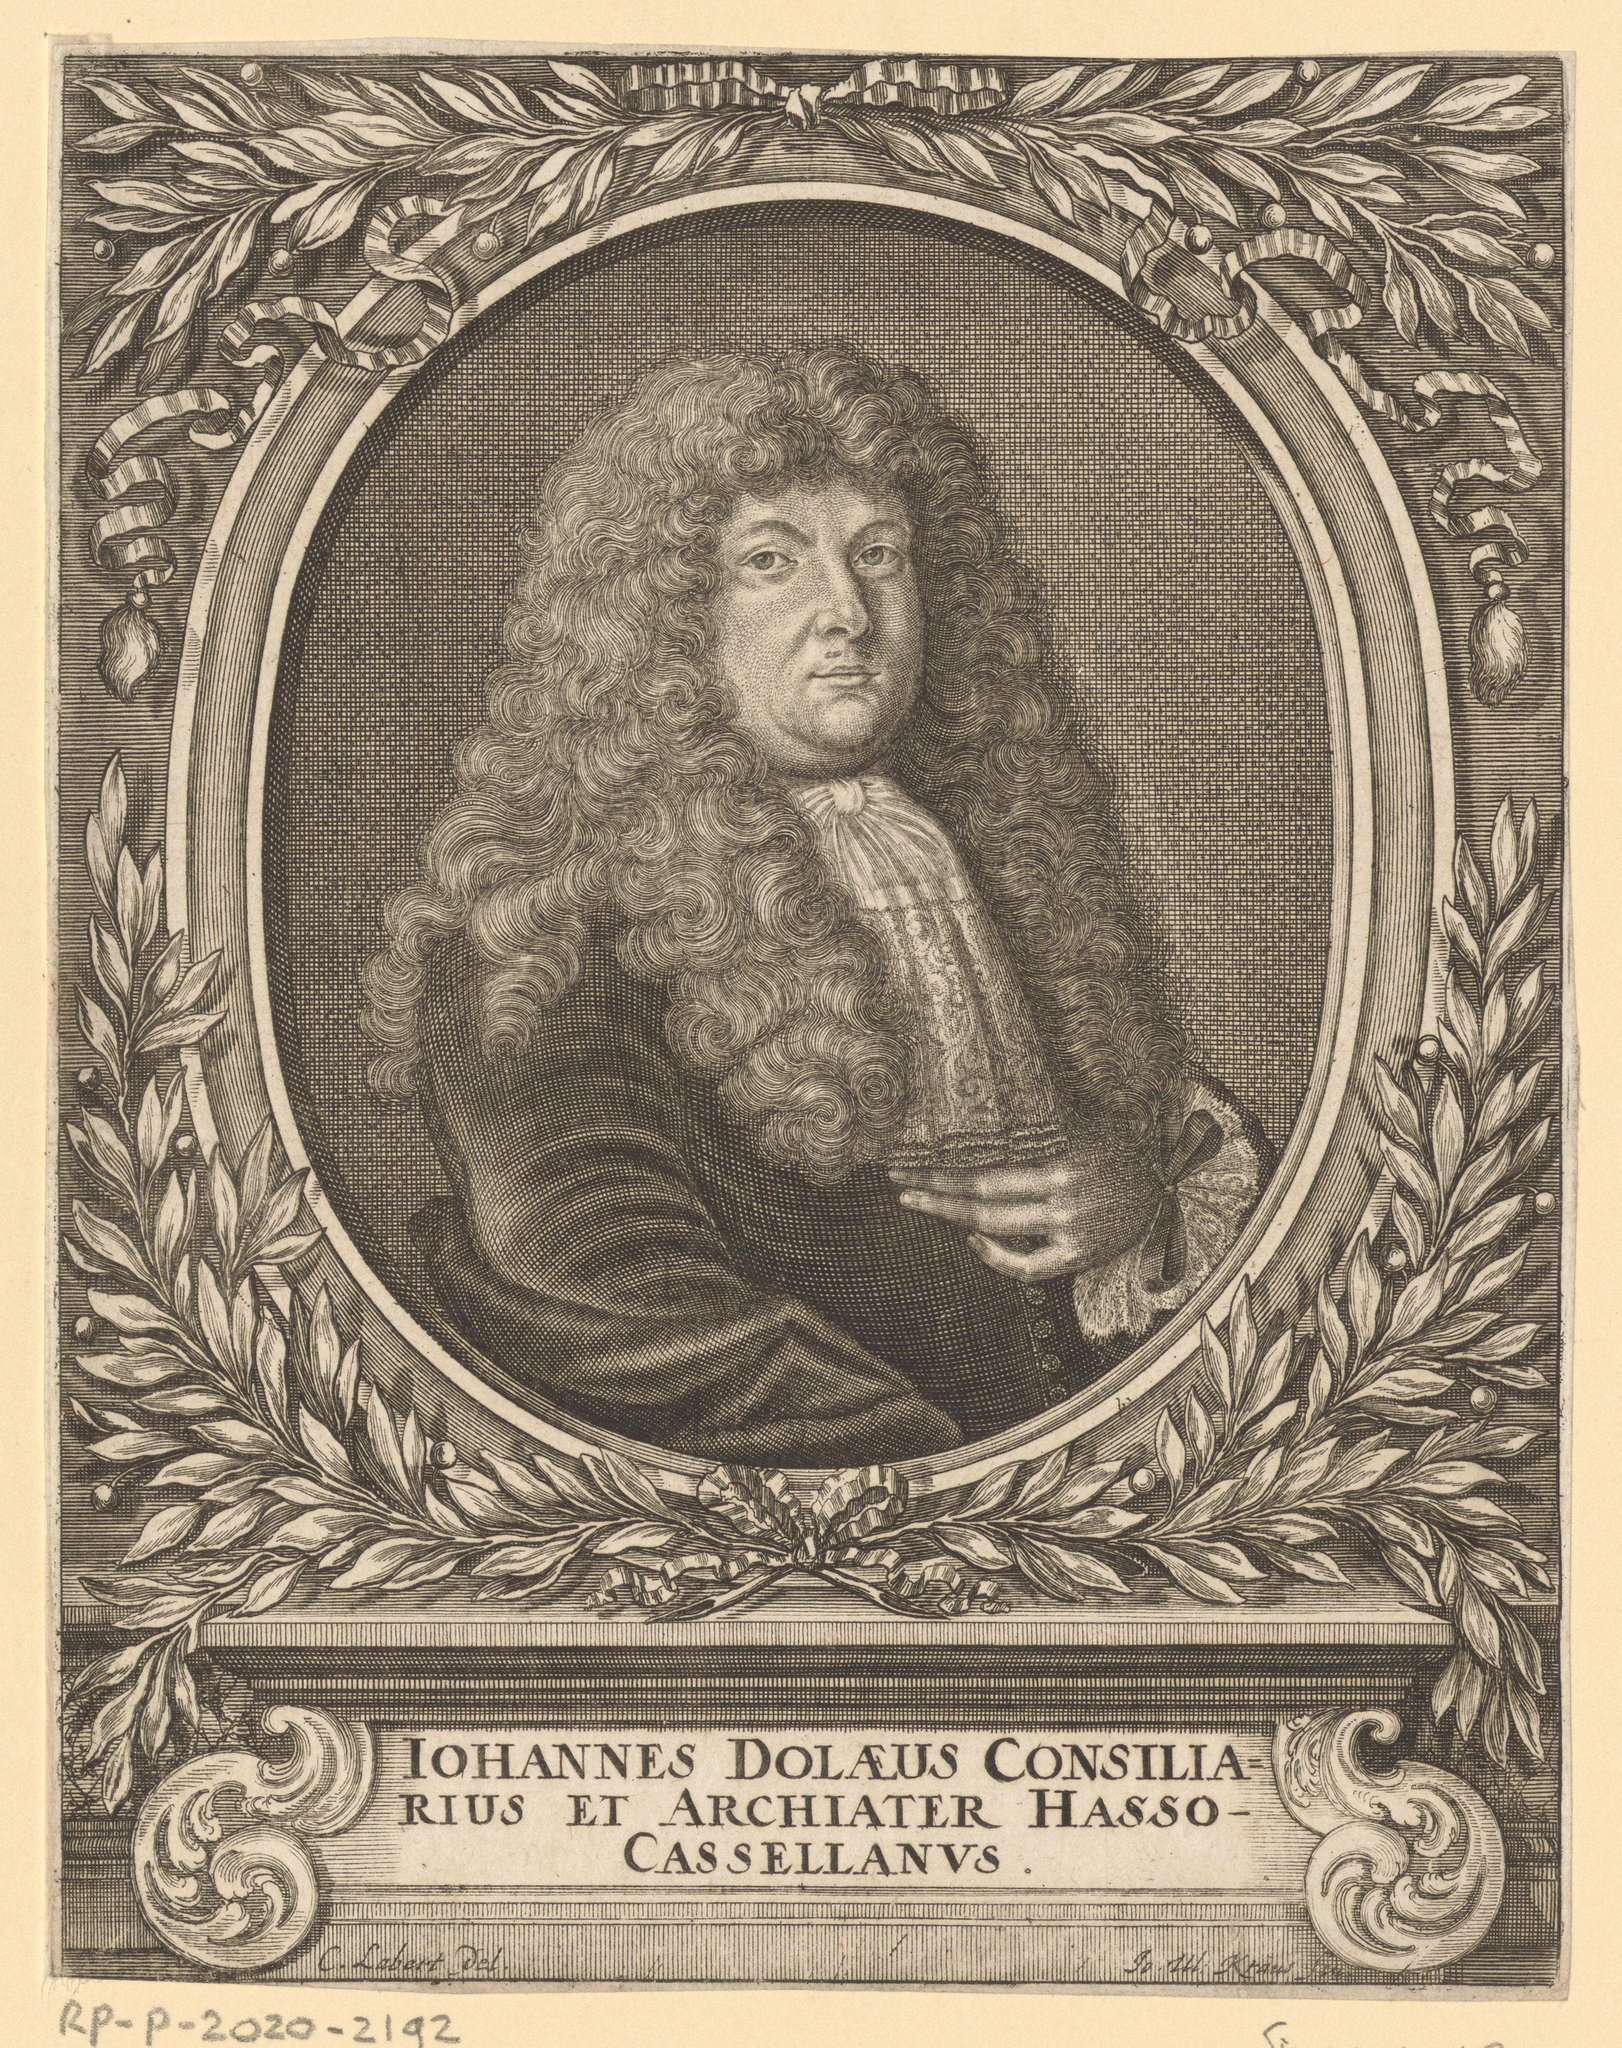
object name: print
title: Portret van Johann Dolaeus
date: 1689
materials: paper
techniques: engraving, etching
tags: historical persons, physician, doctor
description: Prent mogelijk uit: Dolaeus, Johann. Encyclopaedia chirurgica rationalis (...). Frankfurt am Main: Friedrich Knoch, 1689.